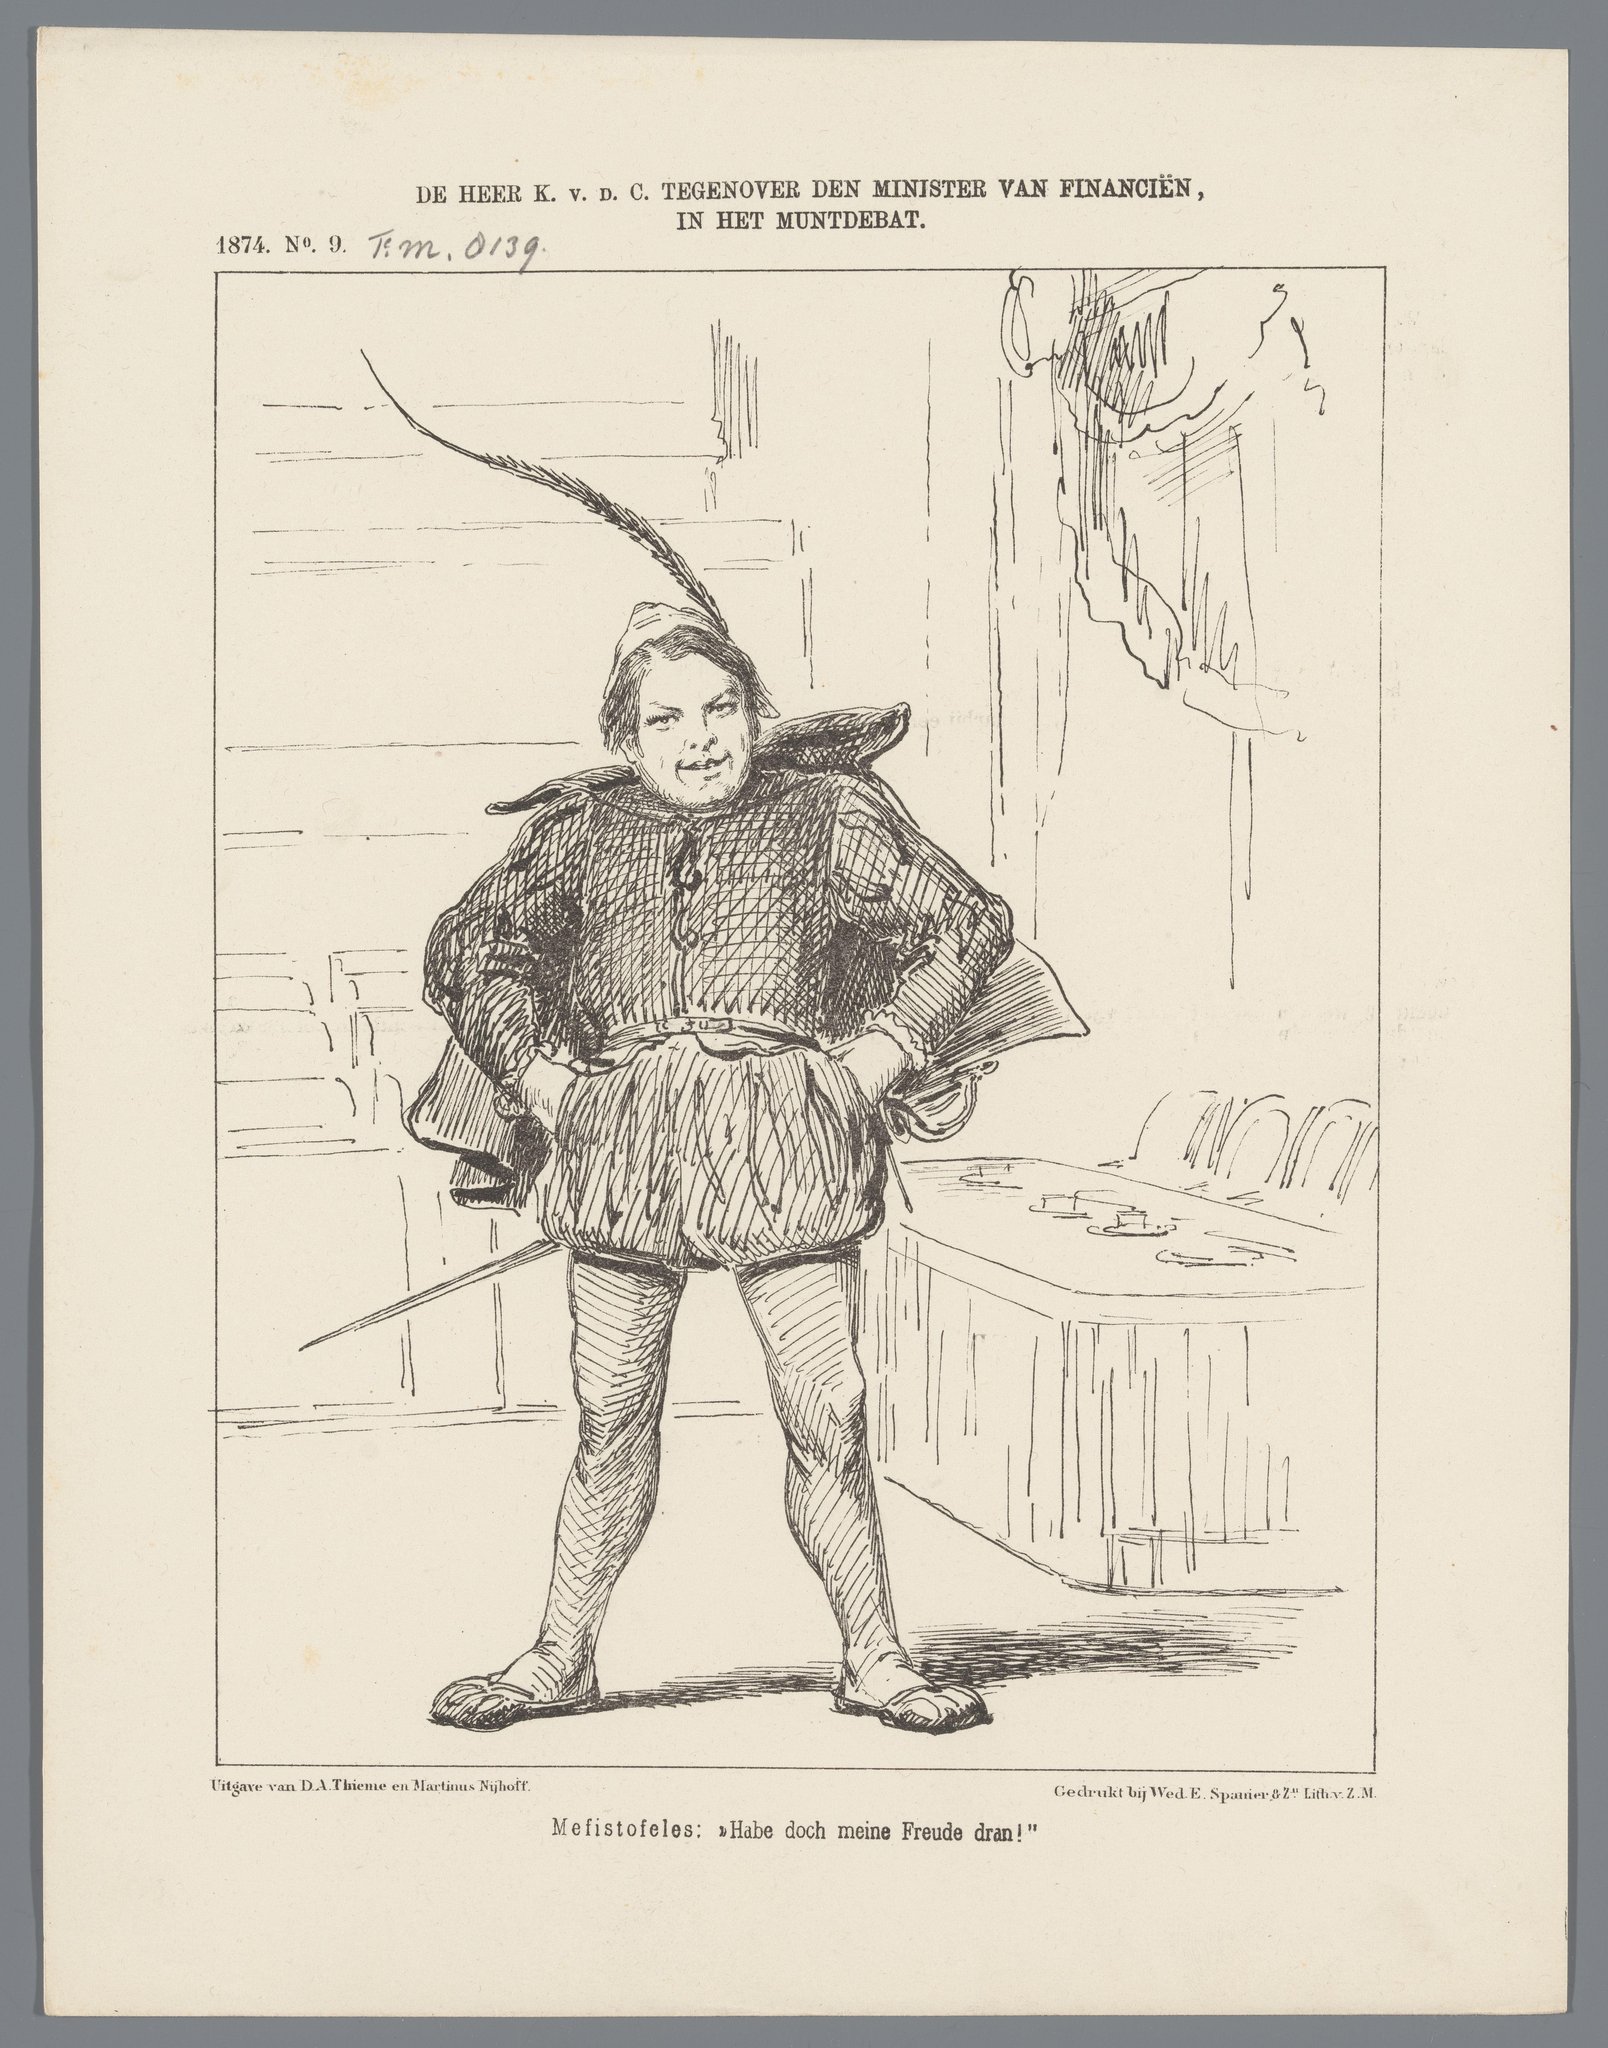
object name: print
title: Spotprent op het muntdebat, 1874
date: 1874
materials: paper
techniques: lithograph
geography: netherlands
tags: mephistopheles, name of the demonic tempter in the literary versions of the faust legends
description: Spotprent op het debat over de muntstandaard, 1874. Kappeyne van de Coppello als Mephistoles. Plaat verschenen bij het weekblad De Nederlandsche Spectator, nr. 9, 1874.